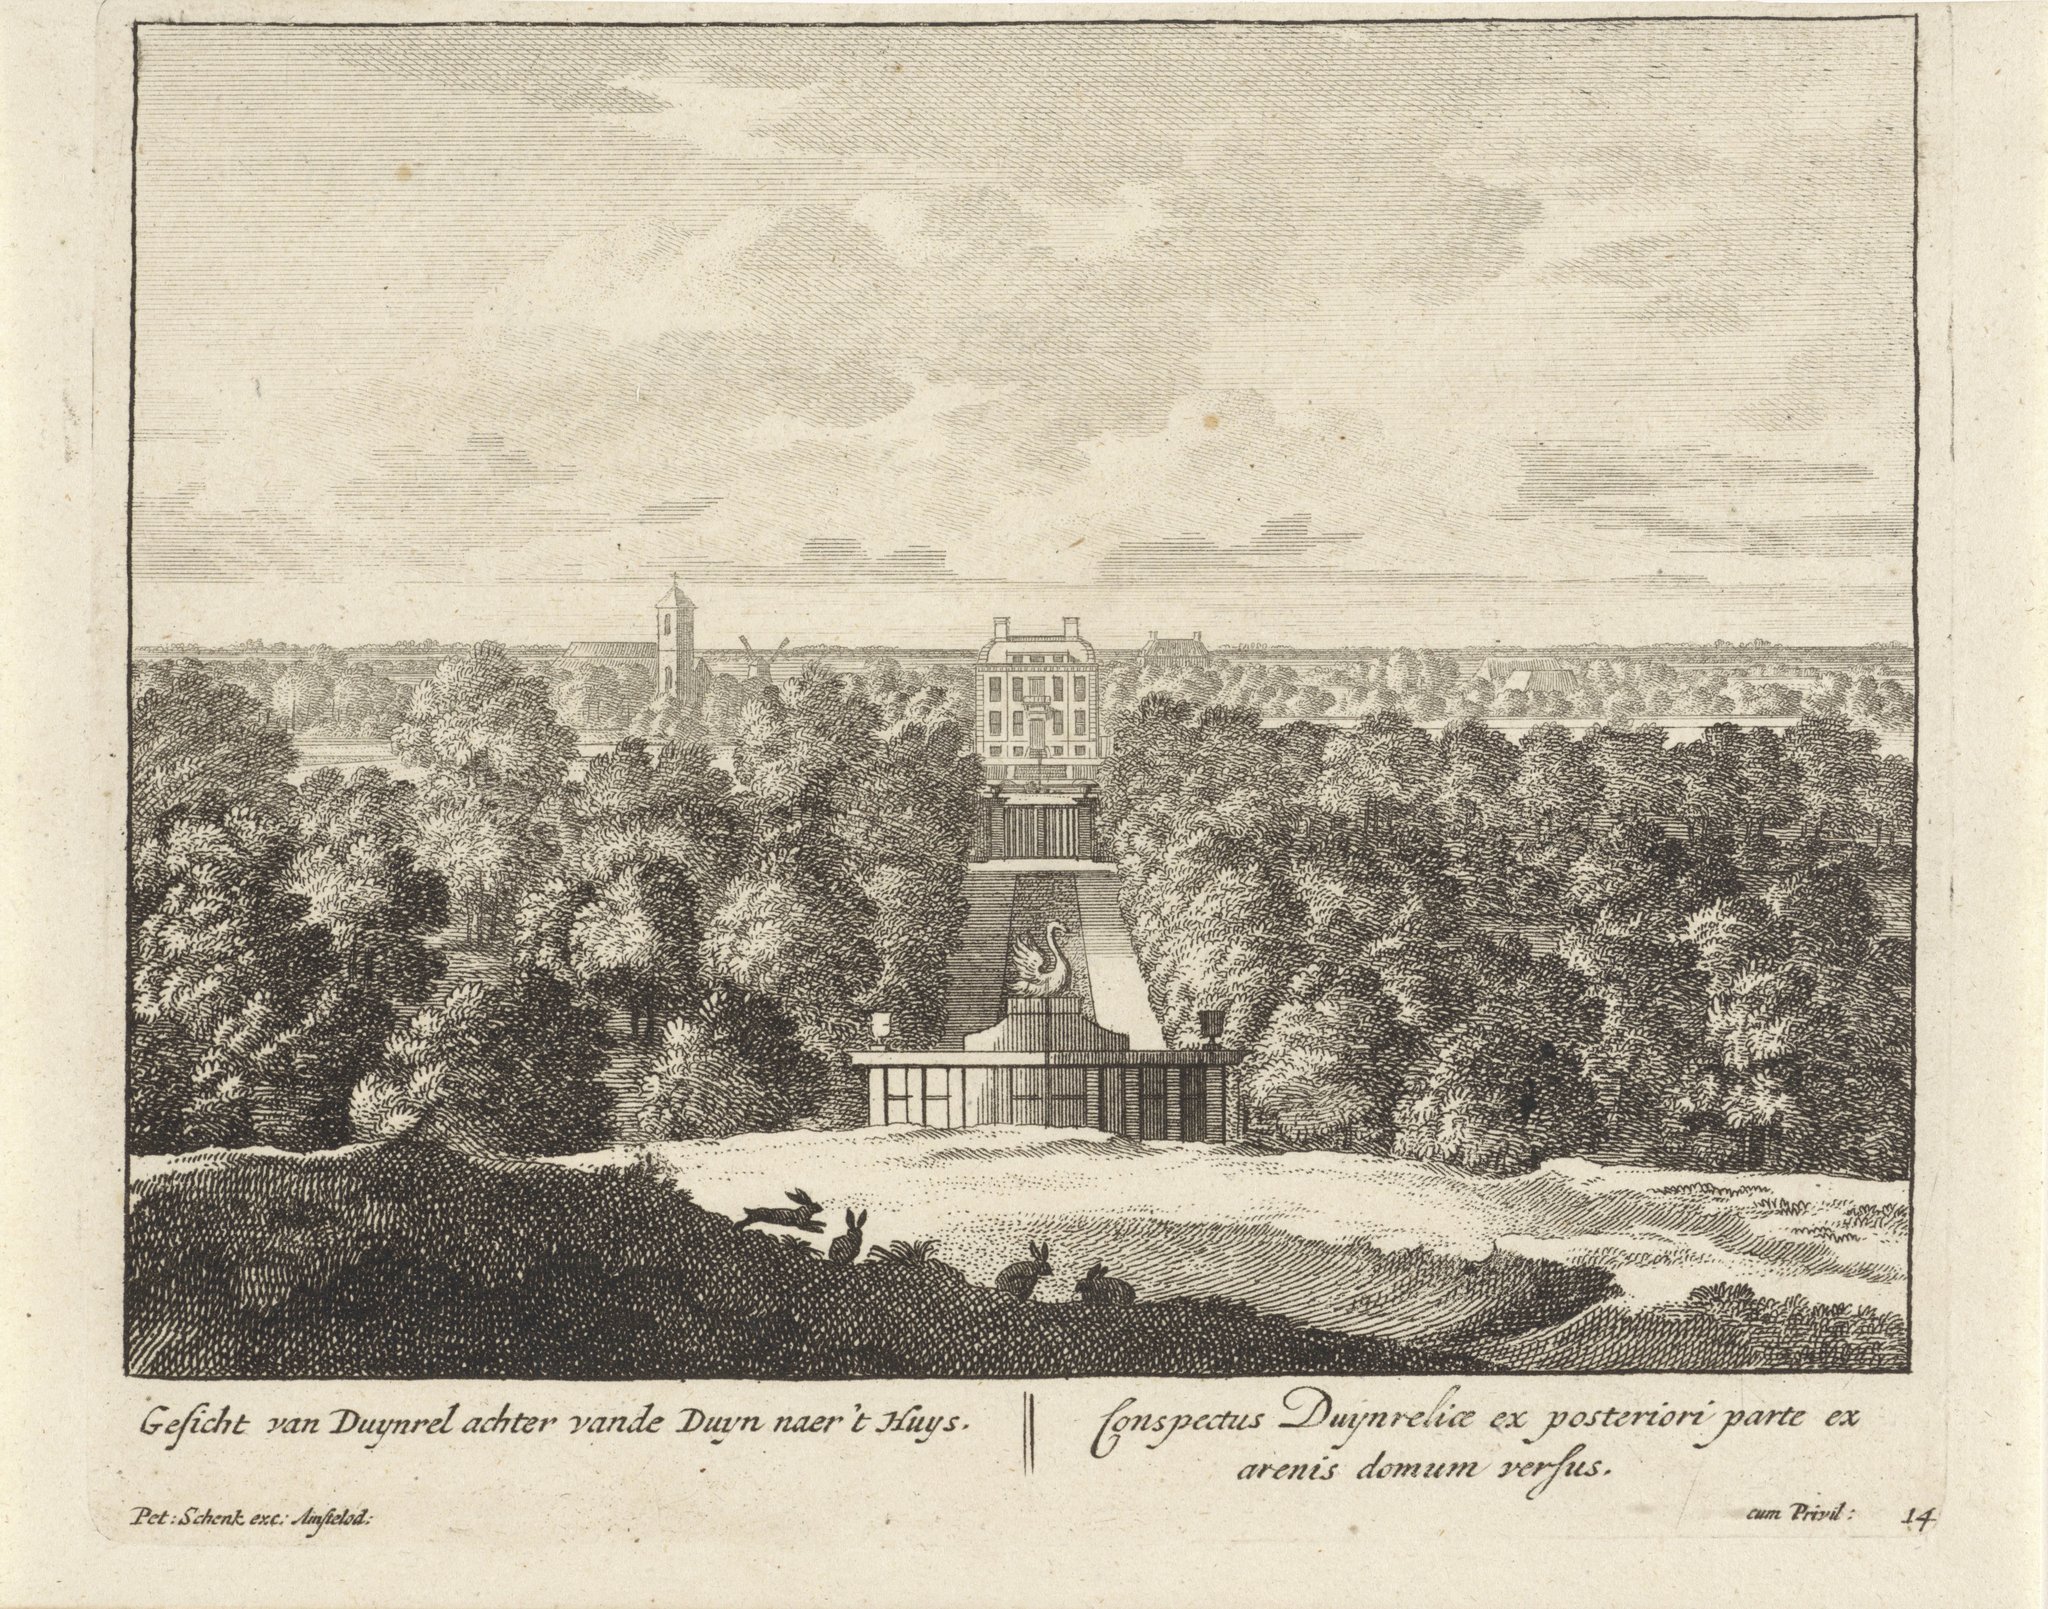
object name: print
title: Gesicht van Duynrel achter vande duyn naer 't huys / Conspectus Duynreliae ex posteriori parte ex arenis domum versus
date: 1675-1711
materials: paper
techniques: etching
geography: amsterdam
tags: triumphal arch, french or architectonic garden; formal garden, church (exterior), windmill, country-house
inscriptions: collector's mark: Lugt 2228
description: Gezicht op de buitenplaats Duinrell, gezien vanaf de duinen. In het midden de erepoort met daarachter de tuin en het huis. Links op de achtergrond een kerk en een molen. Rechtsonder genummerd: 14. Prent uit een serie van zestien prenten van Duinrell.